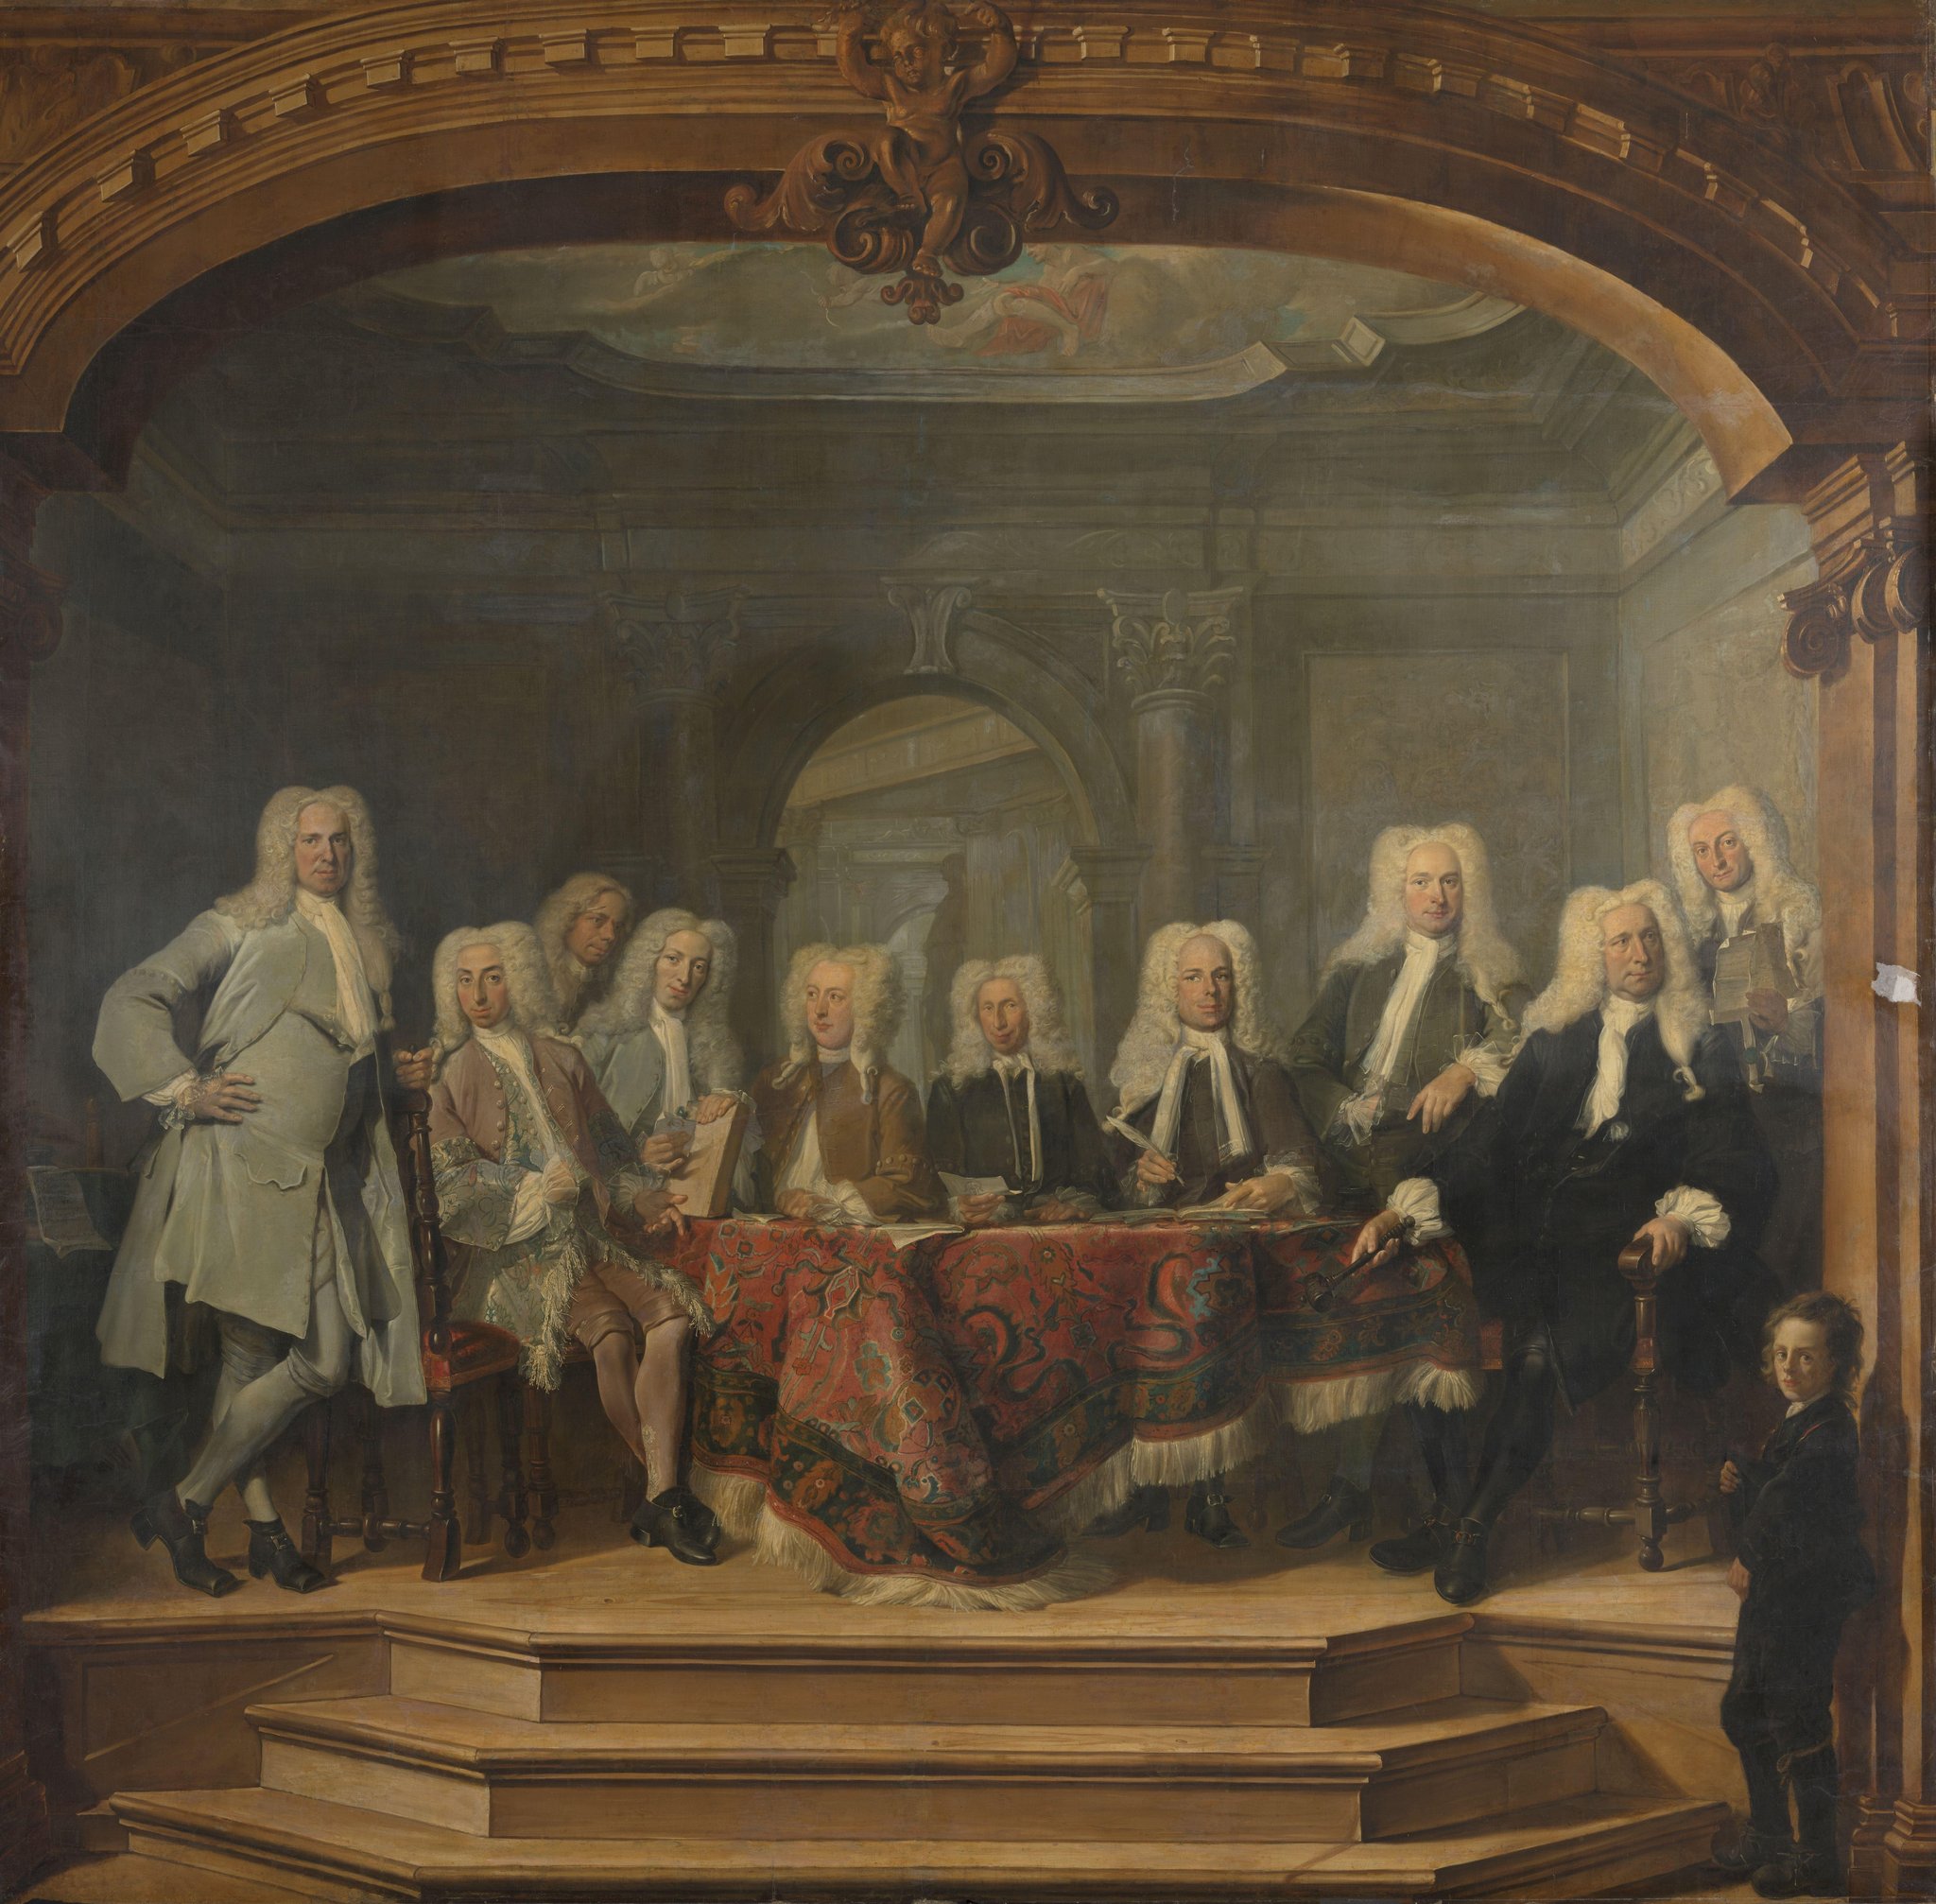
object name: painting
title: Regents of the Aalmoezeniersweeshuis Orphanage in Amsterdam, 1729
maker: cornelis troost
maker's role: draughtsman, painter, print maker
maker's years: 1696-1750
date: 1729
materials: canvas, oil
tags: board, esp. governors, trustees, etc. (dutch: 'regenten')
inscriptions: signature and date: ‘C. Troost inventor et fecit 1729’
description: Groepsportret van de regenten van het Aalmoezeniersweeshuis te Amsterdam in 1729, zittend en staand rond een tafel. Rechts op de voorgrond een weesjongen. Geportretteerd zijn zittend: C. van Westerhoff en Jan Lepeltak. Staande: Theodoor Rogge, L. de Bas, J. van Vliet, C. Commelin II en W. Swarth, in het midden achter de tafel: Ph. Schrijver, A. van Bogaerde en J. Capiteyn (boekhouder).